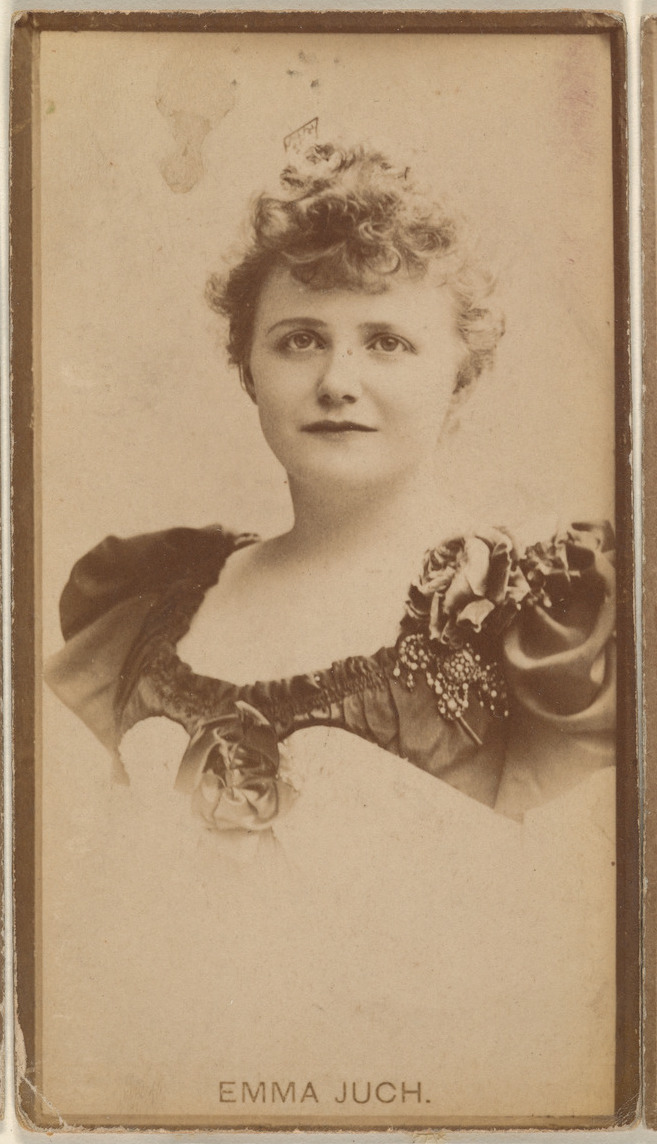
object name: photograph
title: Emma Juch, from the Actresses series (N668)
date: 1888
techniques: albumen silver print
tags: portraits,women,actresses